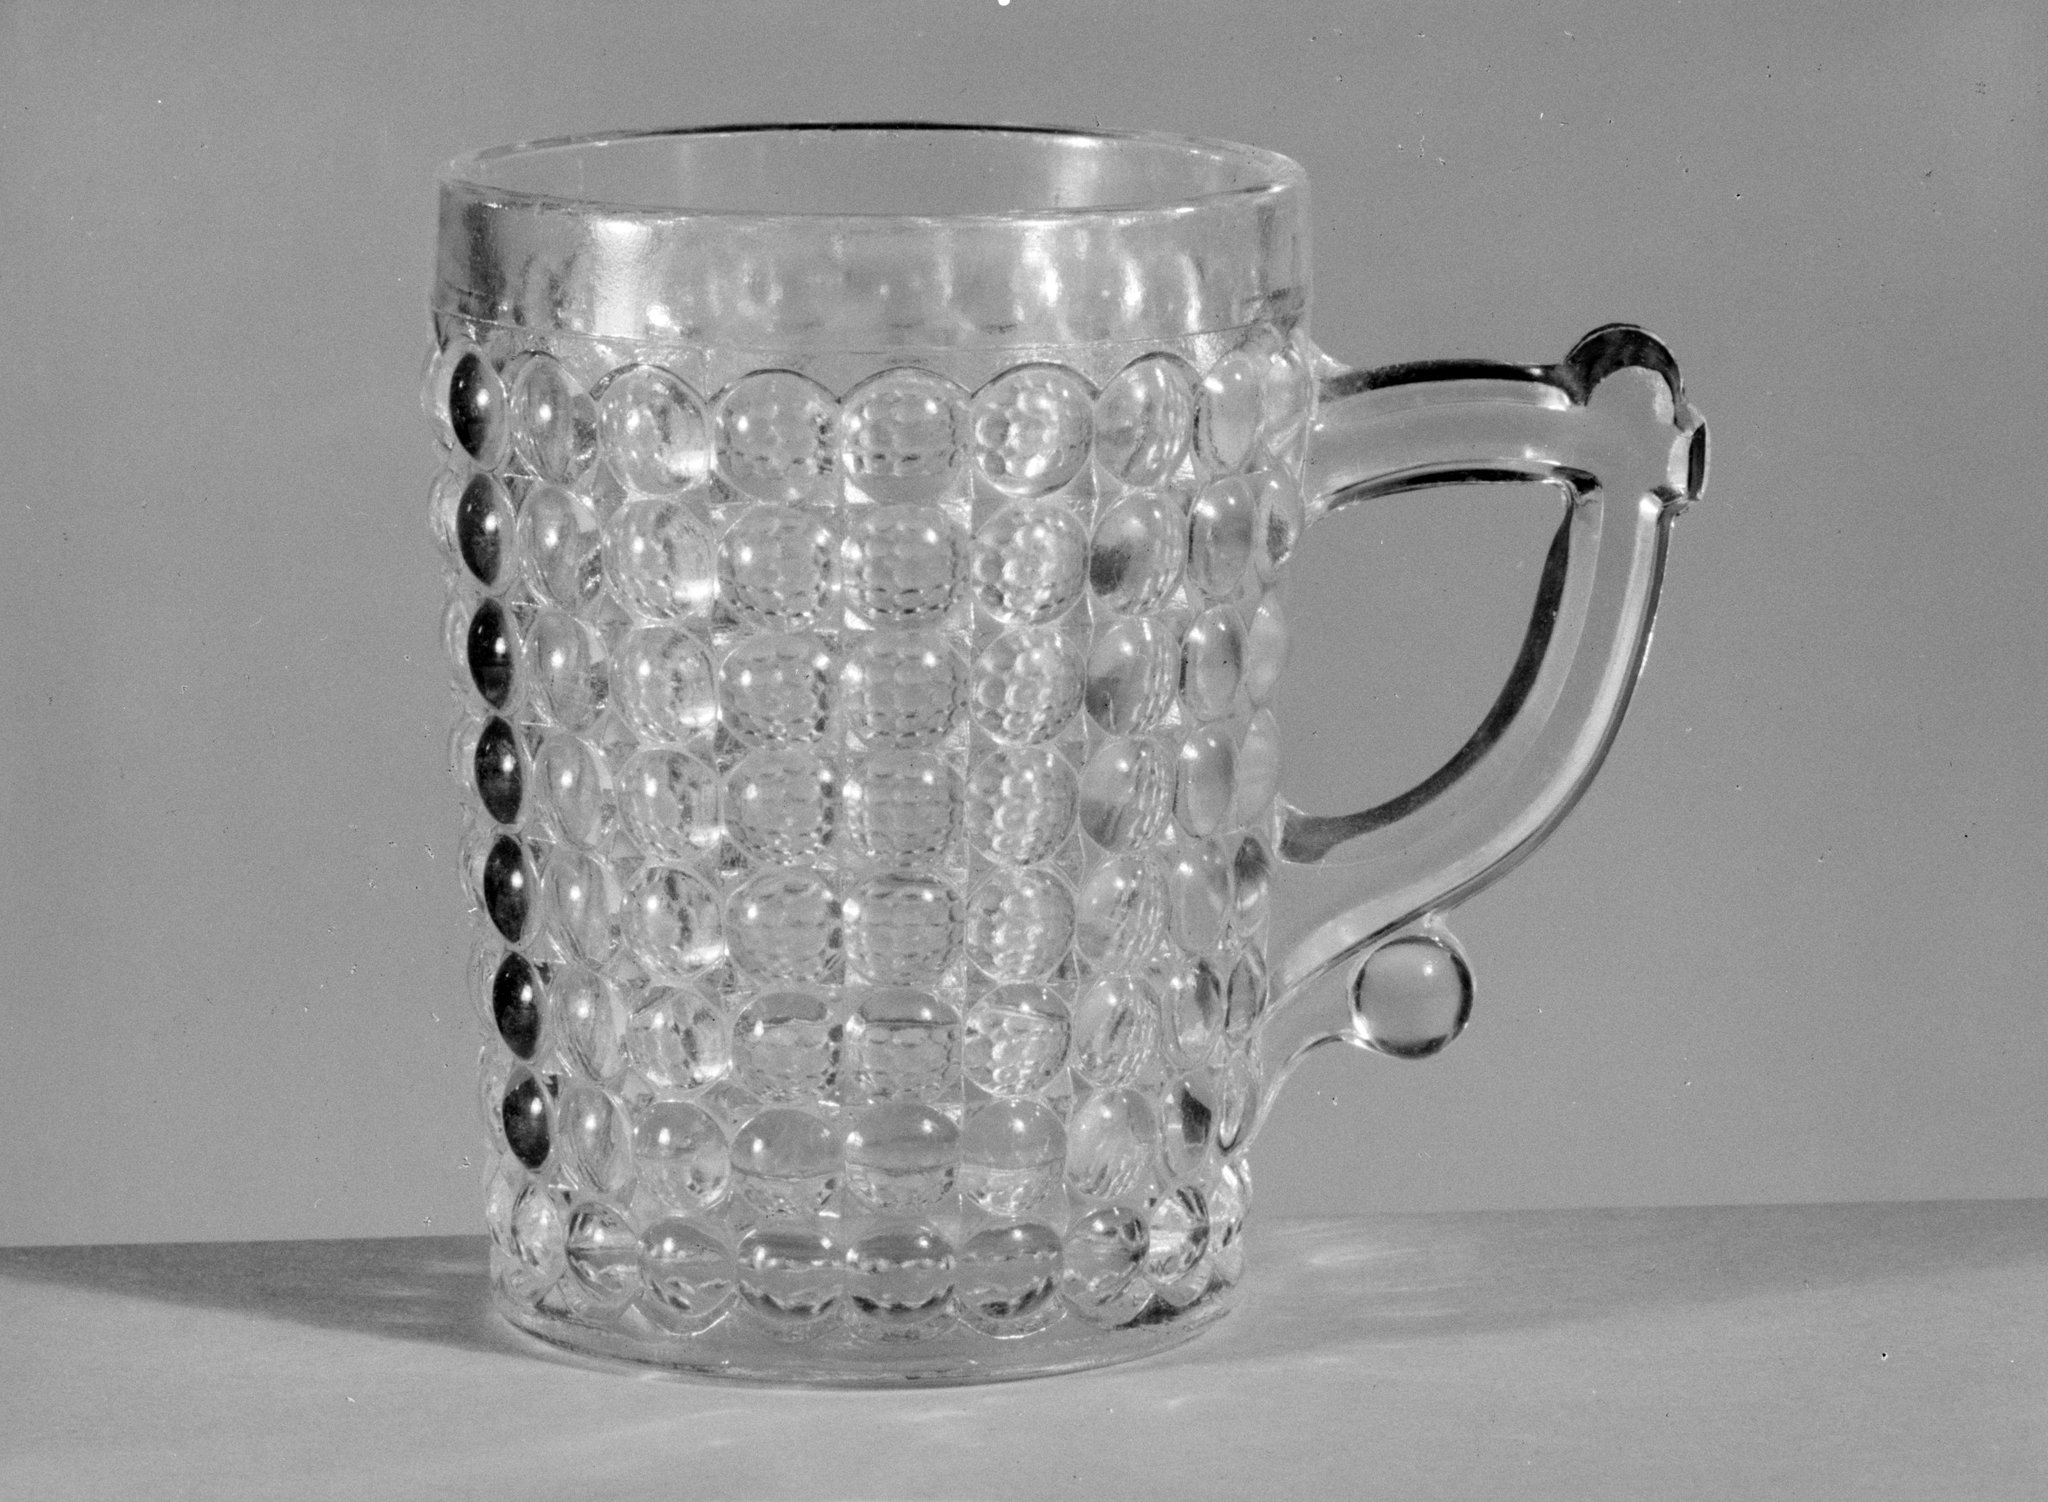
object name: mug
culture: american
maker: adams and company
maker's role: maker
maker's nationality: american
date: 1870-1880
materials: glass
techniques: pressed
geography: united states